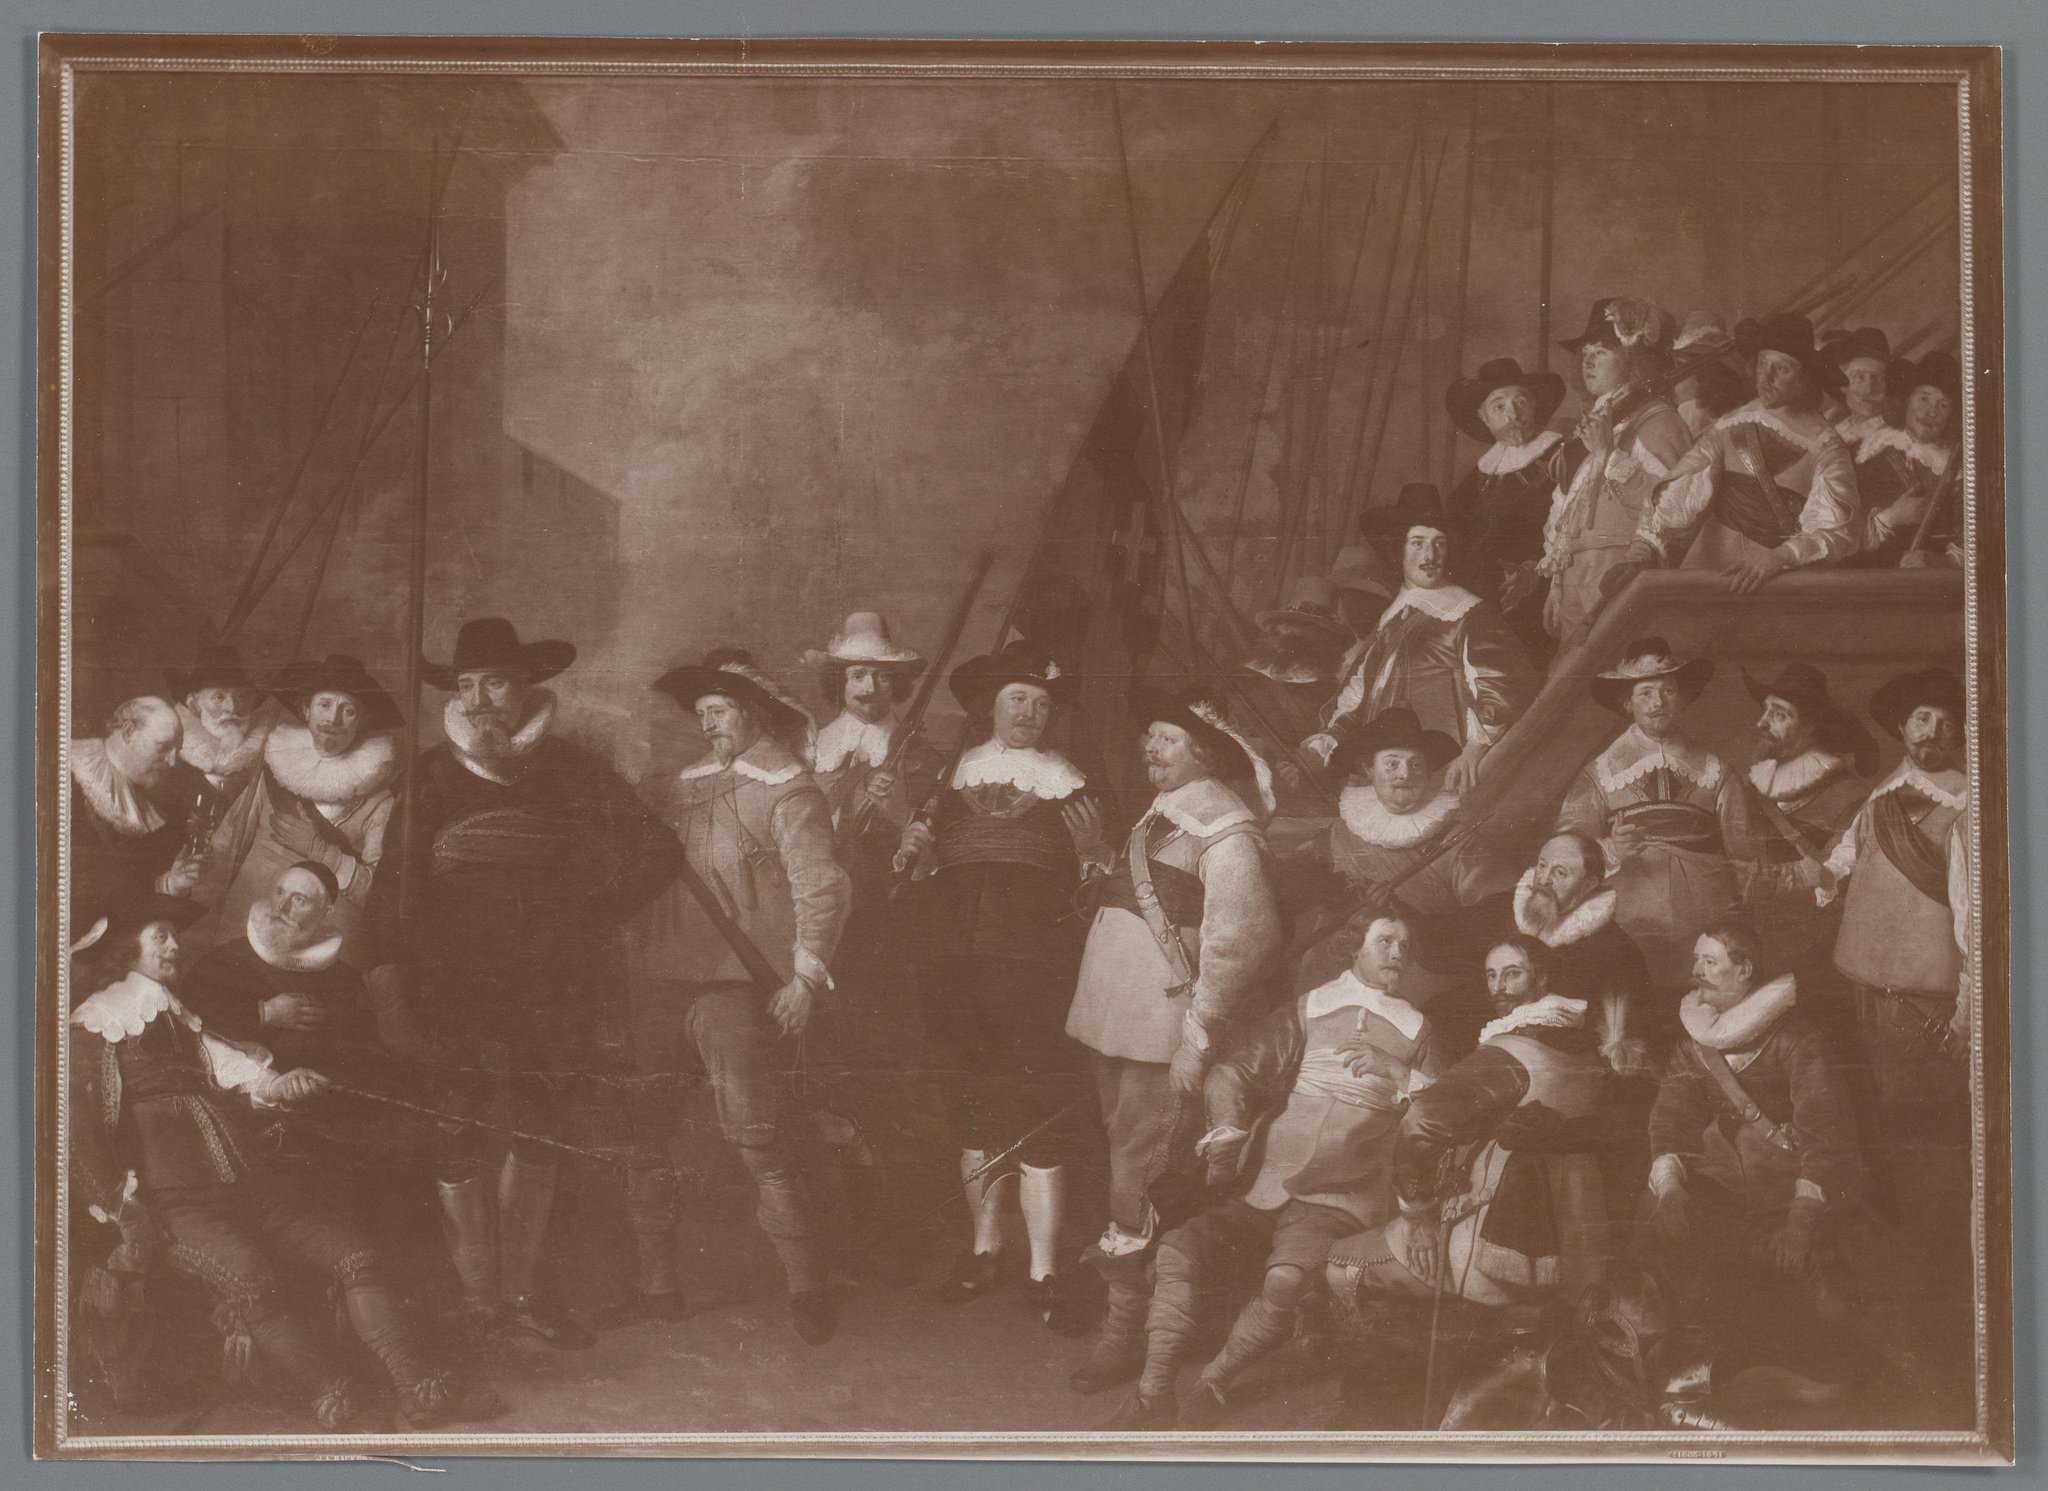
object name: reproduction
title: Fotoreproductie van schilderij van Officieren en andere schutters van wijk V in Amsterdam, door Jacob Adriaensz. Backer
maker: Anonymous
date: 1880-1920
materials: paper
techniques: collodion silver print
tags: amsterdam, mayor, cornelis de graeff, night patrol, public safety, guard duty, keeping sentry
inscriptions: number: ‘580’, inscription: ‘JA. Backer/ Schutterstuk Cloveniersdoelen’